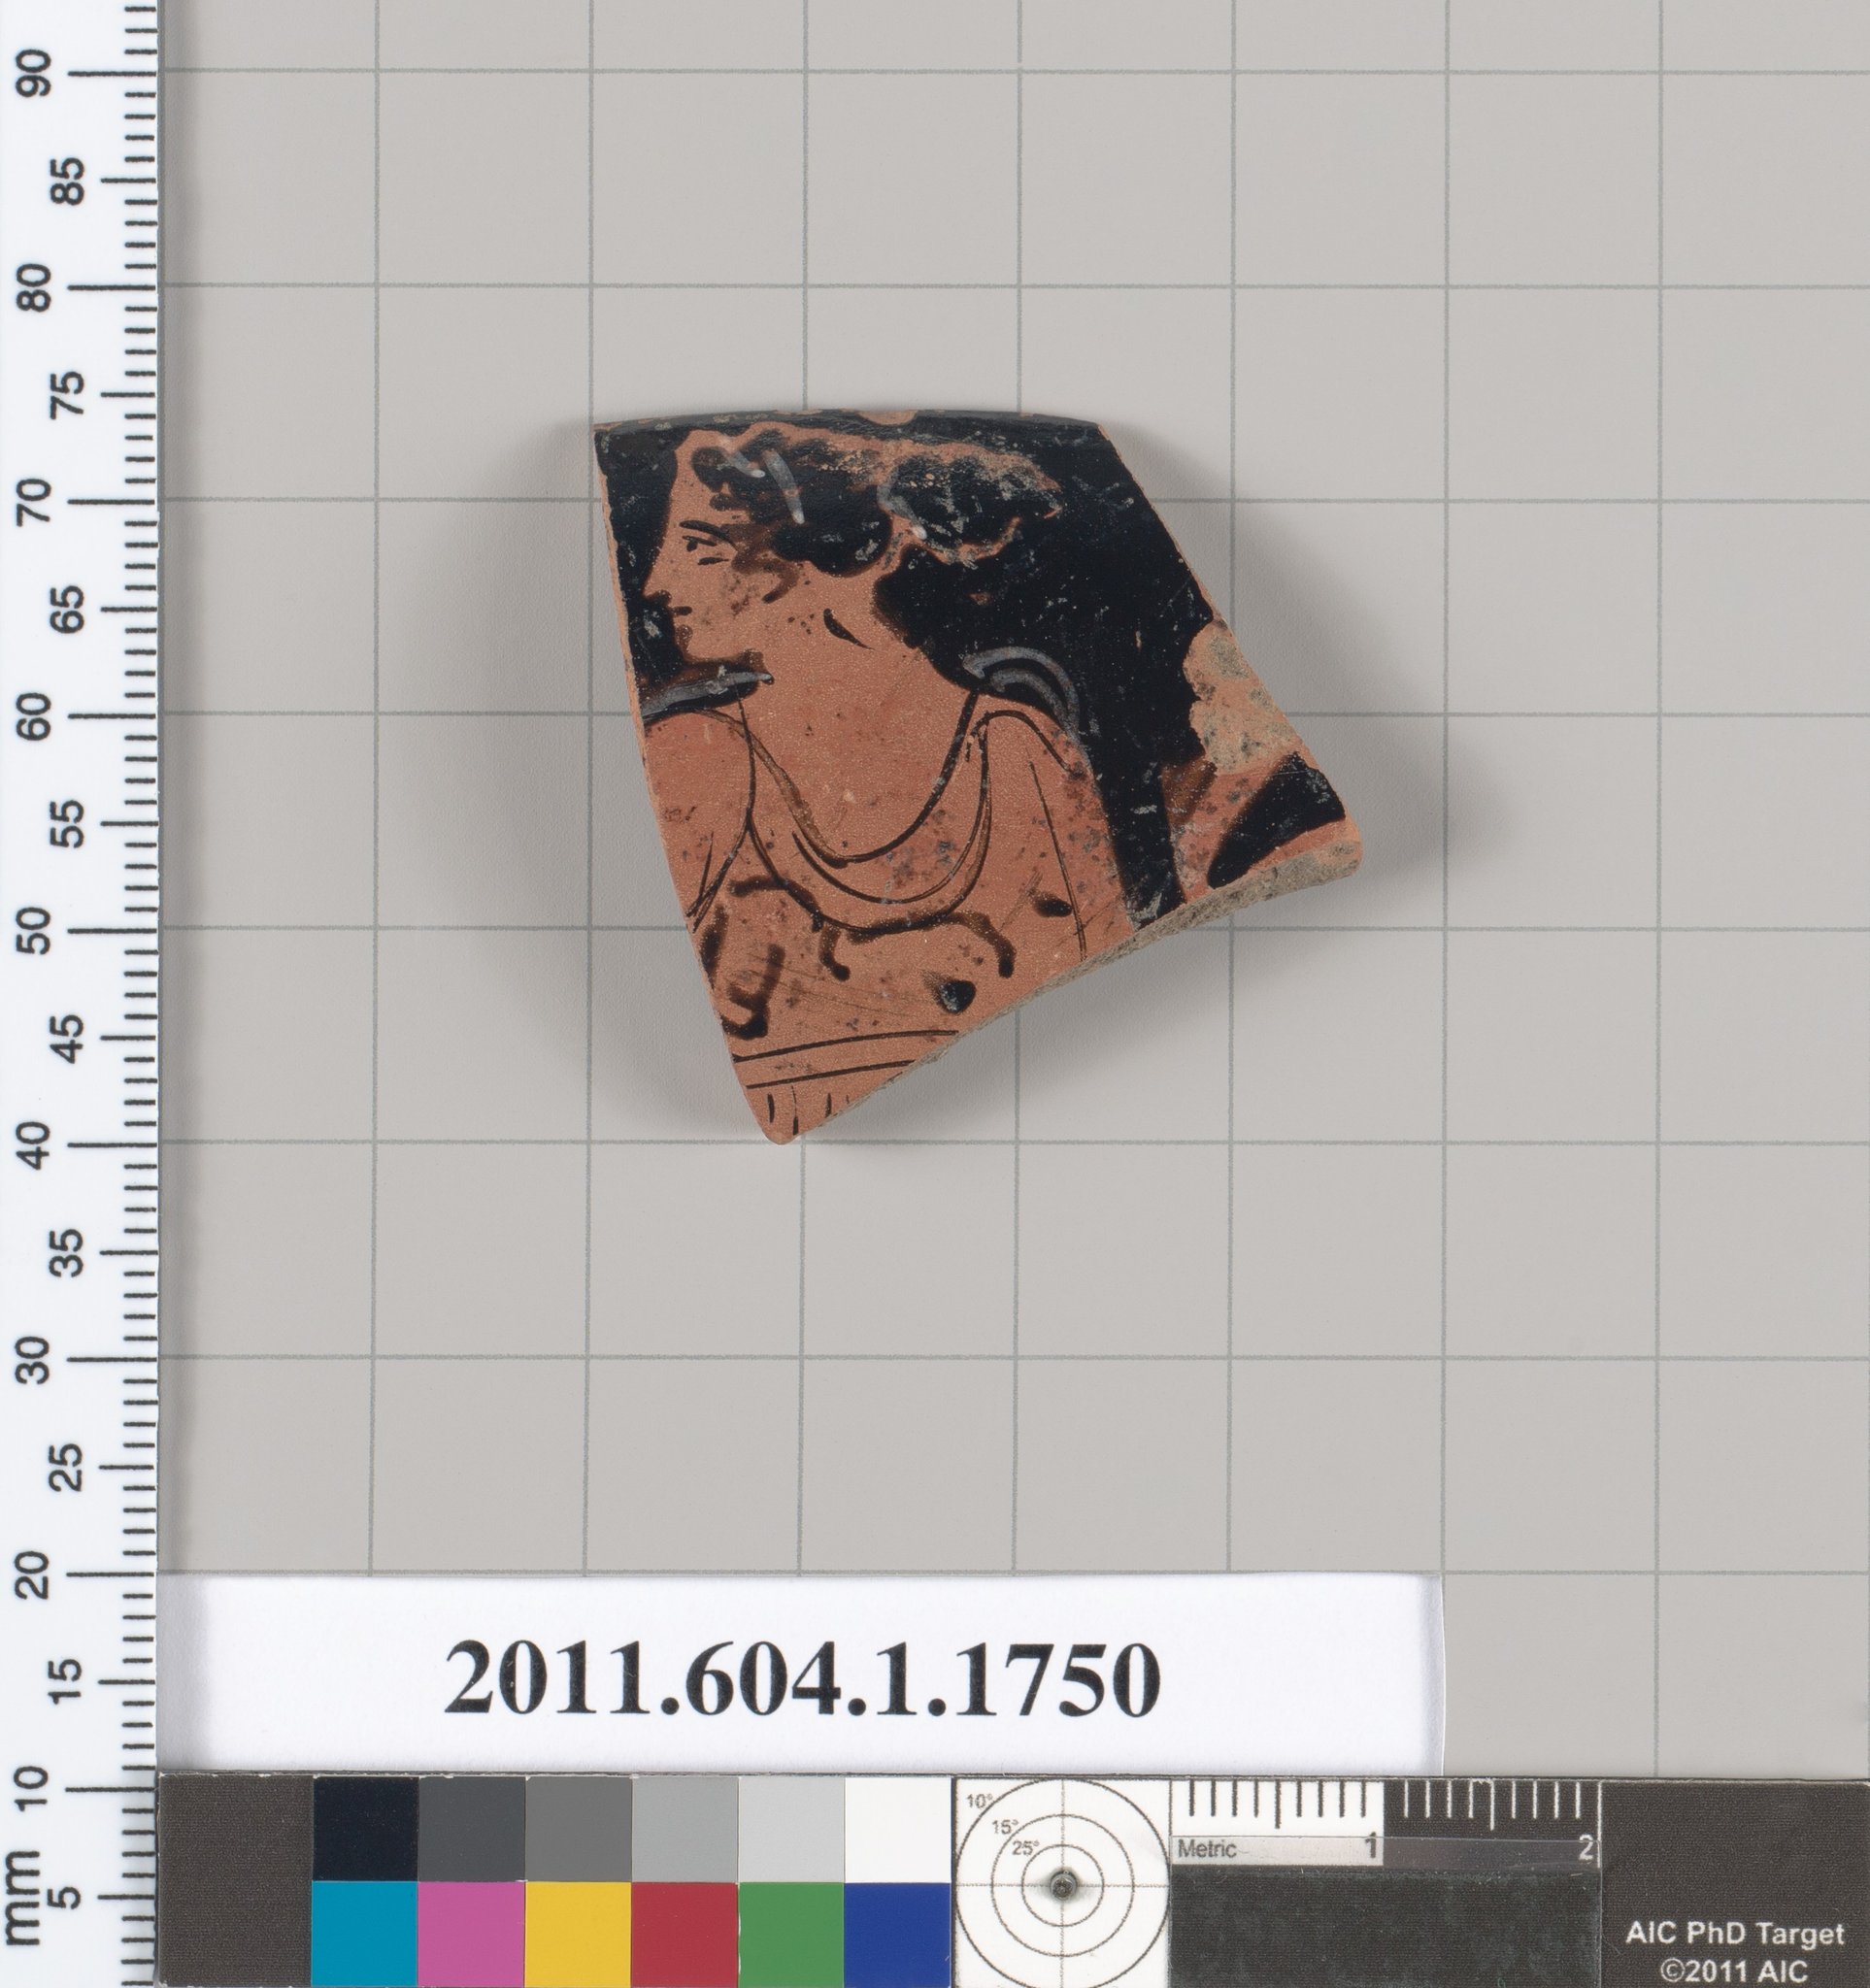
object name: kylix fragment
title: Terracotta rim fragment of a kylix (drinking cup)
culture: greek, attic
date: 467-435 BCE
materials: terracotta